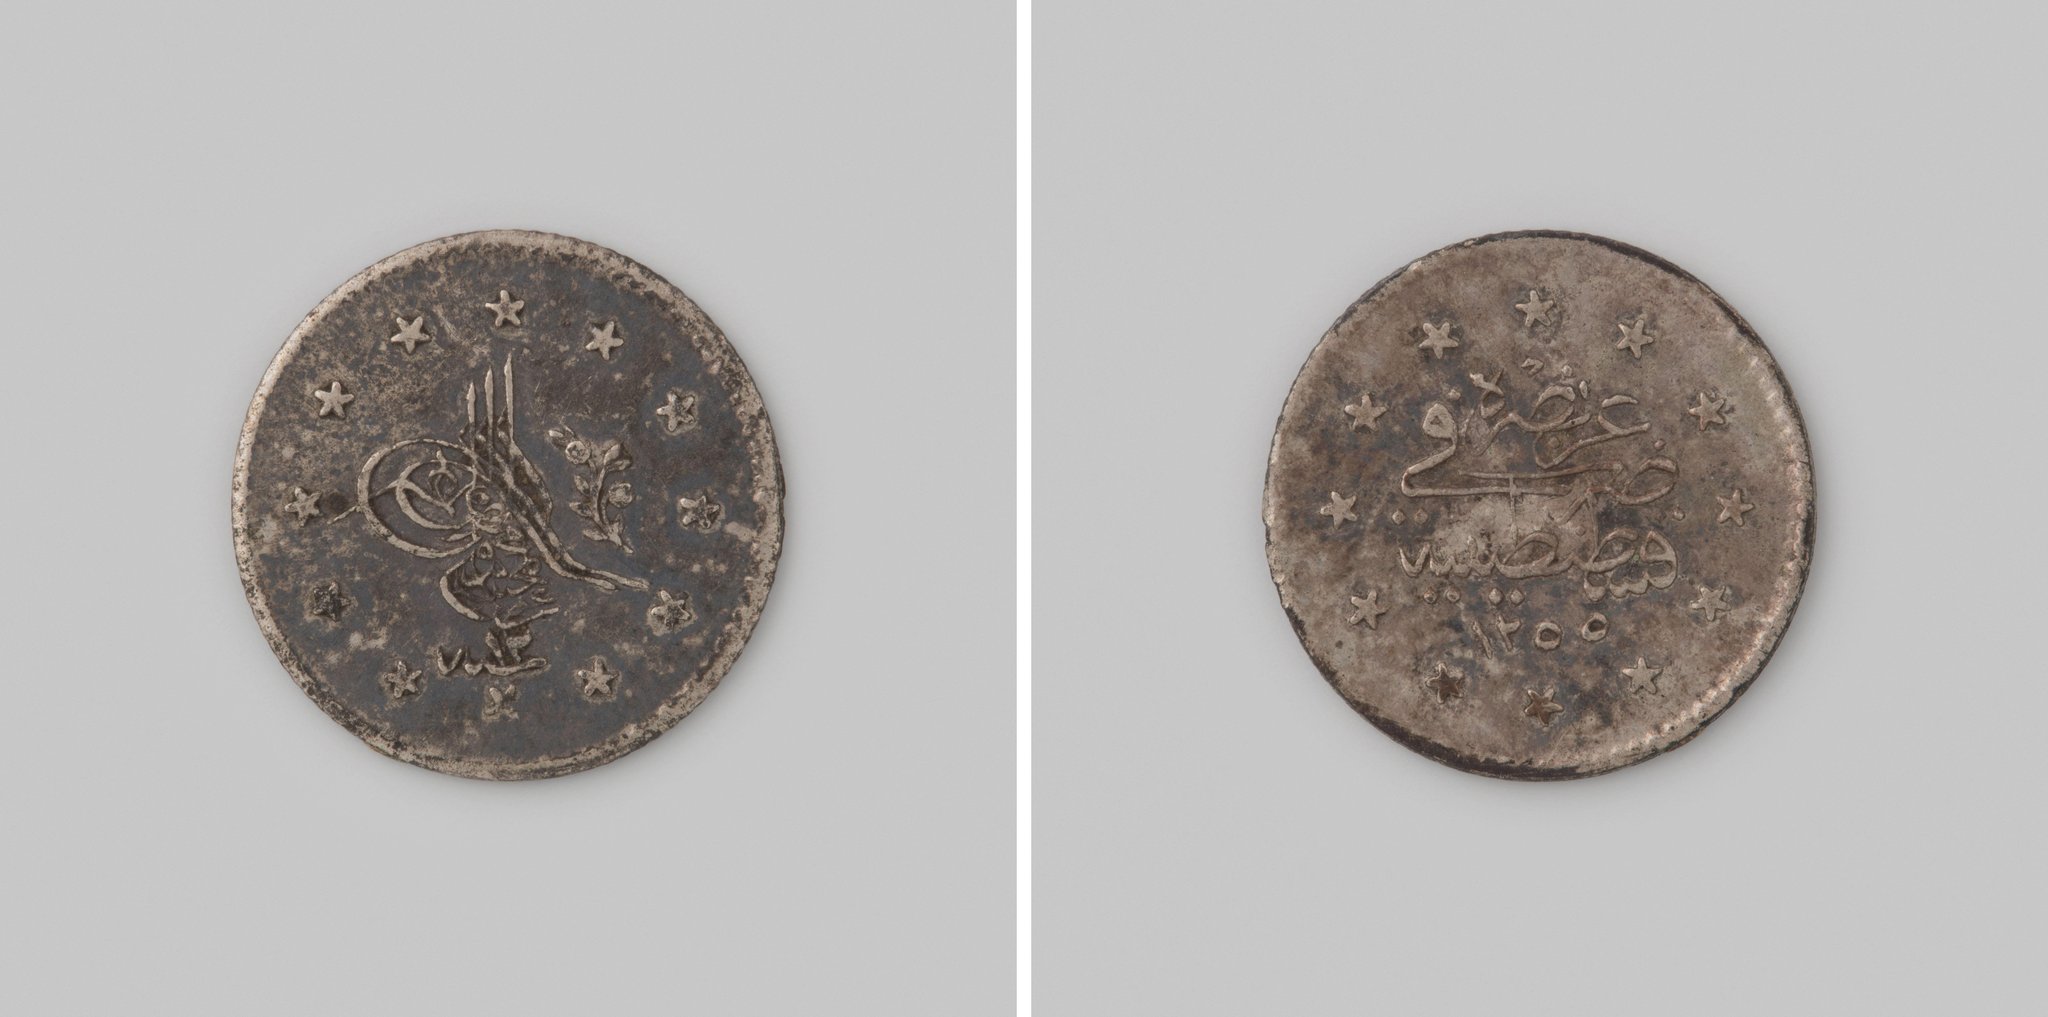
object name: coin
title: Kurush uit Turkije van sultan Abdul Medjid, regeringsjaar 14 [=1852]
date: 1852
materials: silver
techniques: striking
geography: constantinople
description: Zilveren munt. Voorzijde: binnen ring van sterren tughra met rechts daarvan takje met bladeren. Onder tughra aanduiding regeringsjaar: 14. Keerzijde: binnen ring van sterren drieregelig opschrift in Arabische letters met muntplaats-aanduiding: Constantinopel. Onder muntplaats-aanduiding jaar van aantreden: 1255 [=1839].